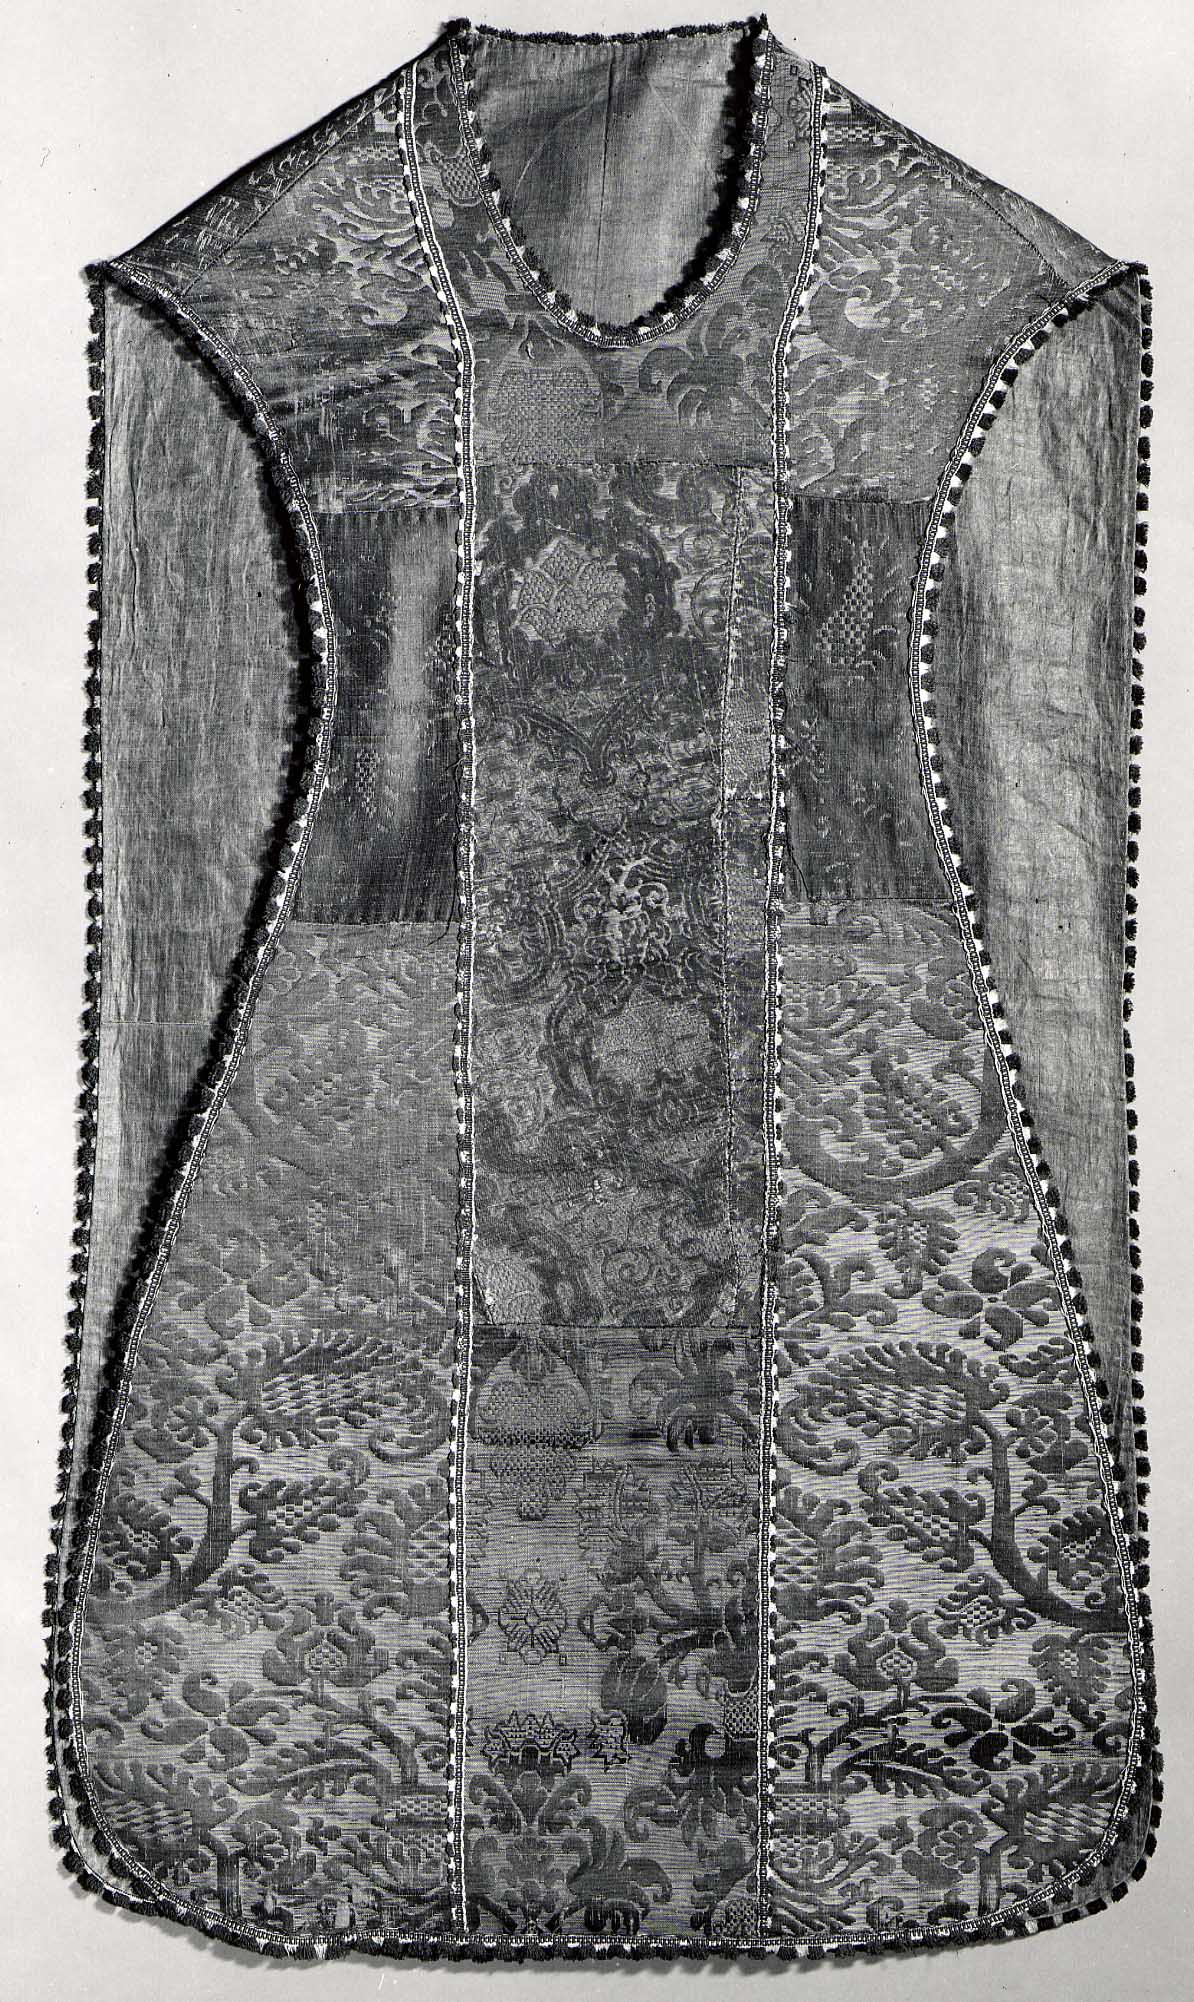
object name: chasuble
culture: spanish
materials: linen, metal, silk